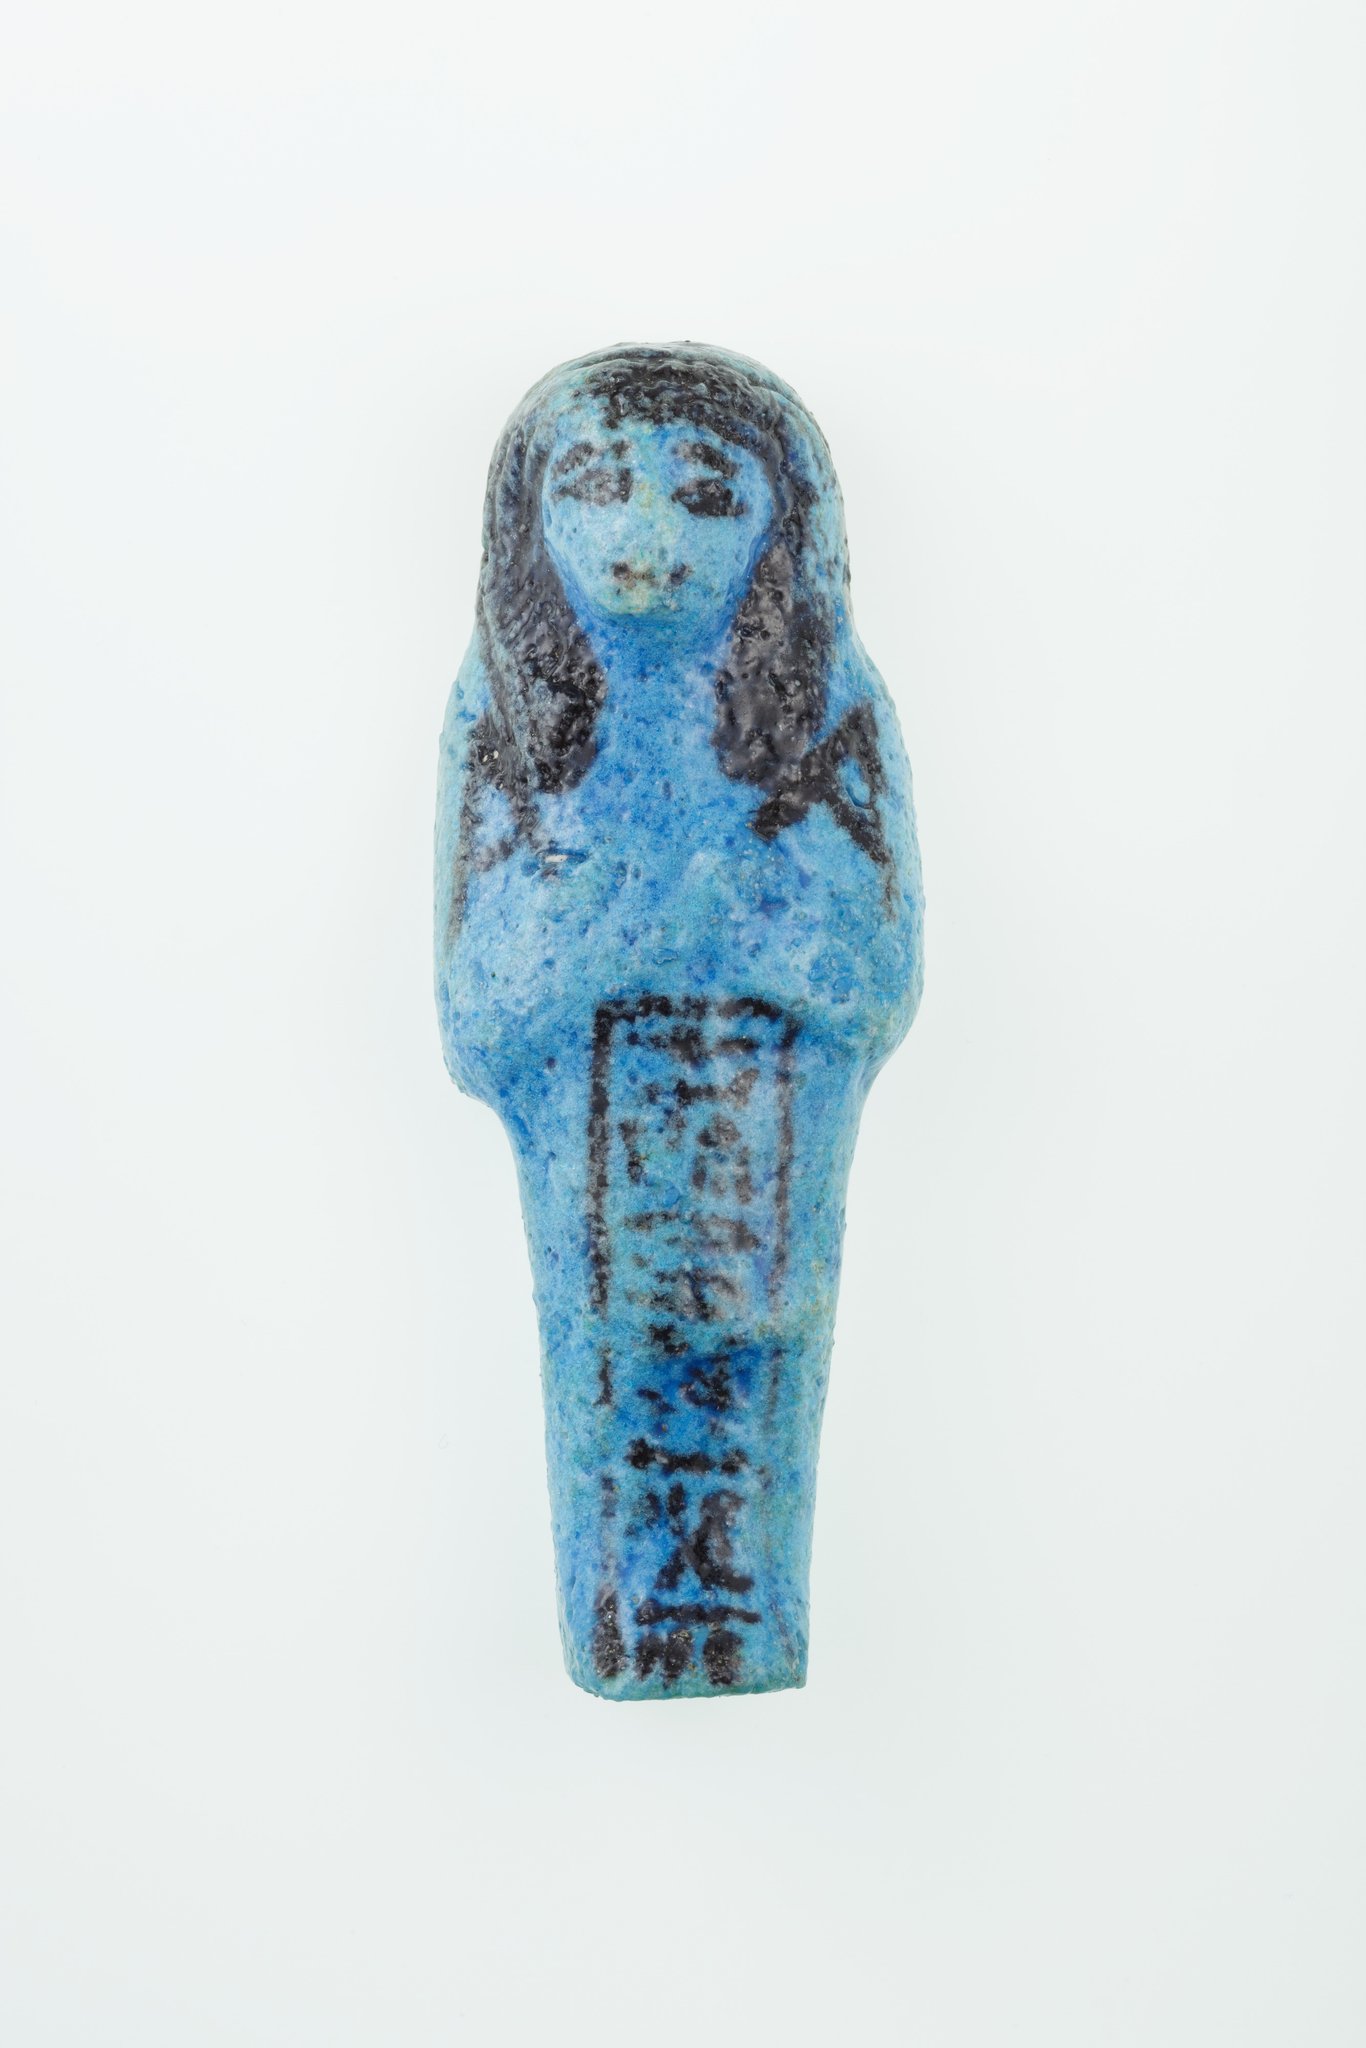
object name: shabti, worker, nauny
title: Worker Shabti of Nauny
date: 1050 BCE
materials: faience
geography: egypt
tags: hieroglyphs